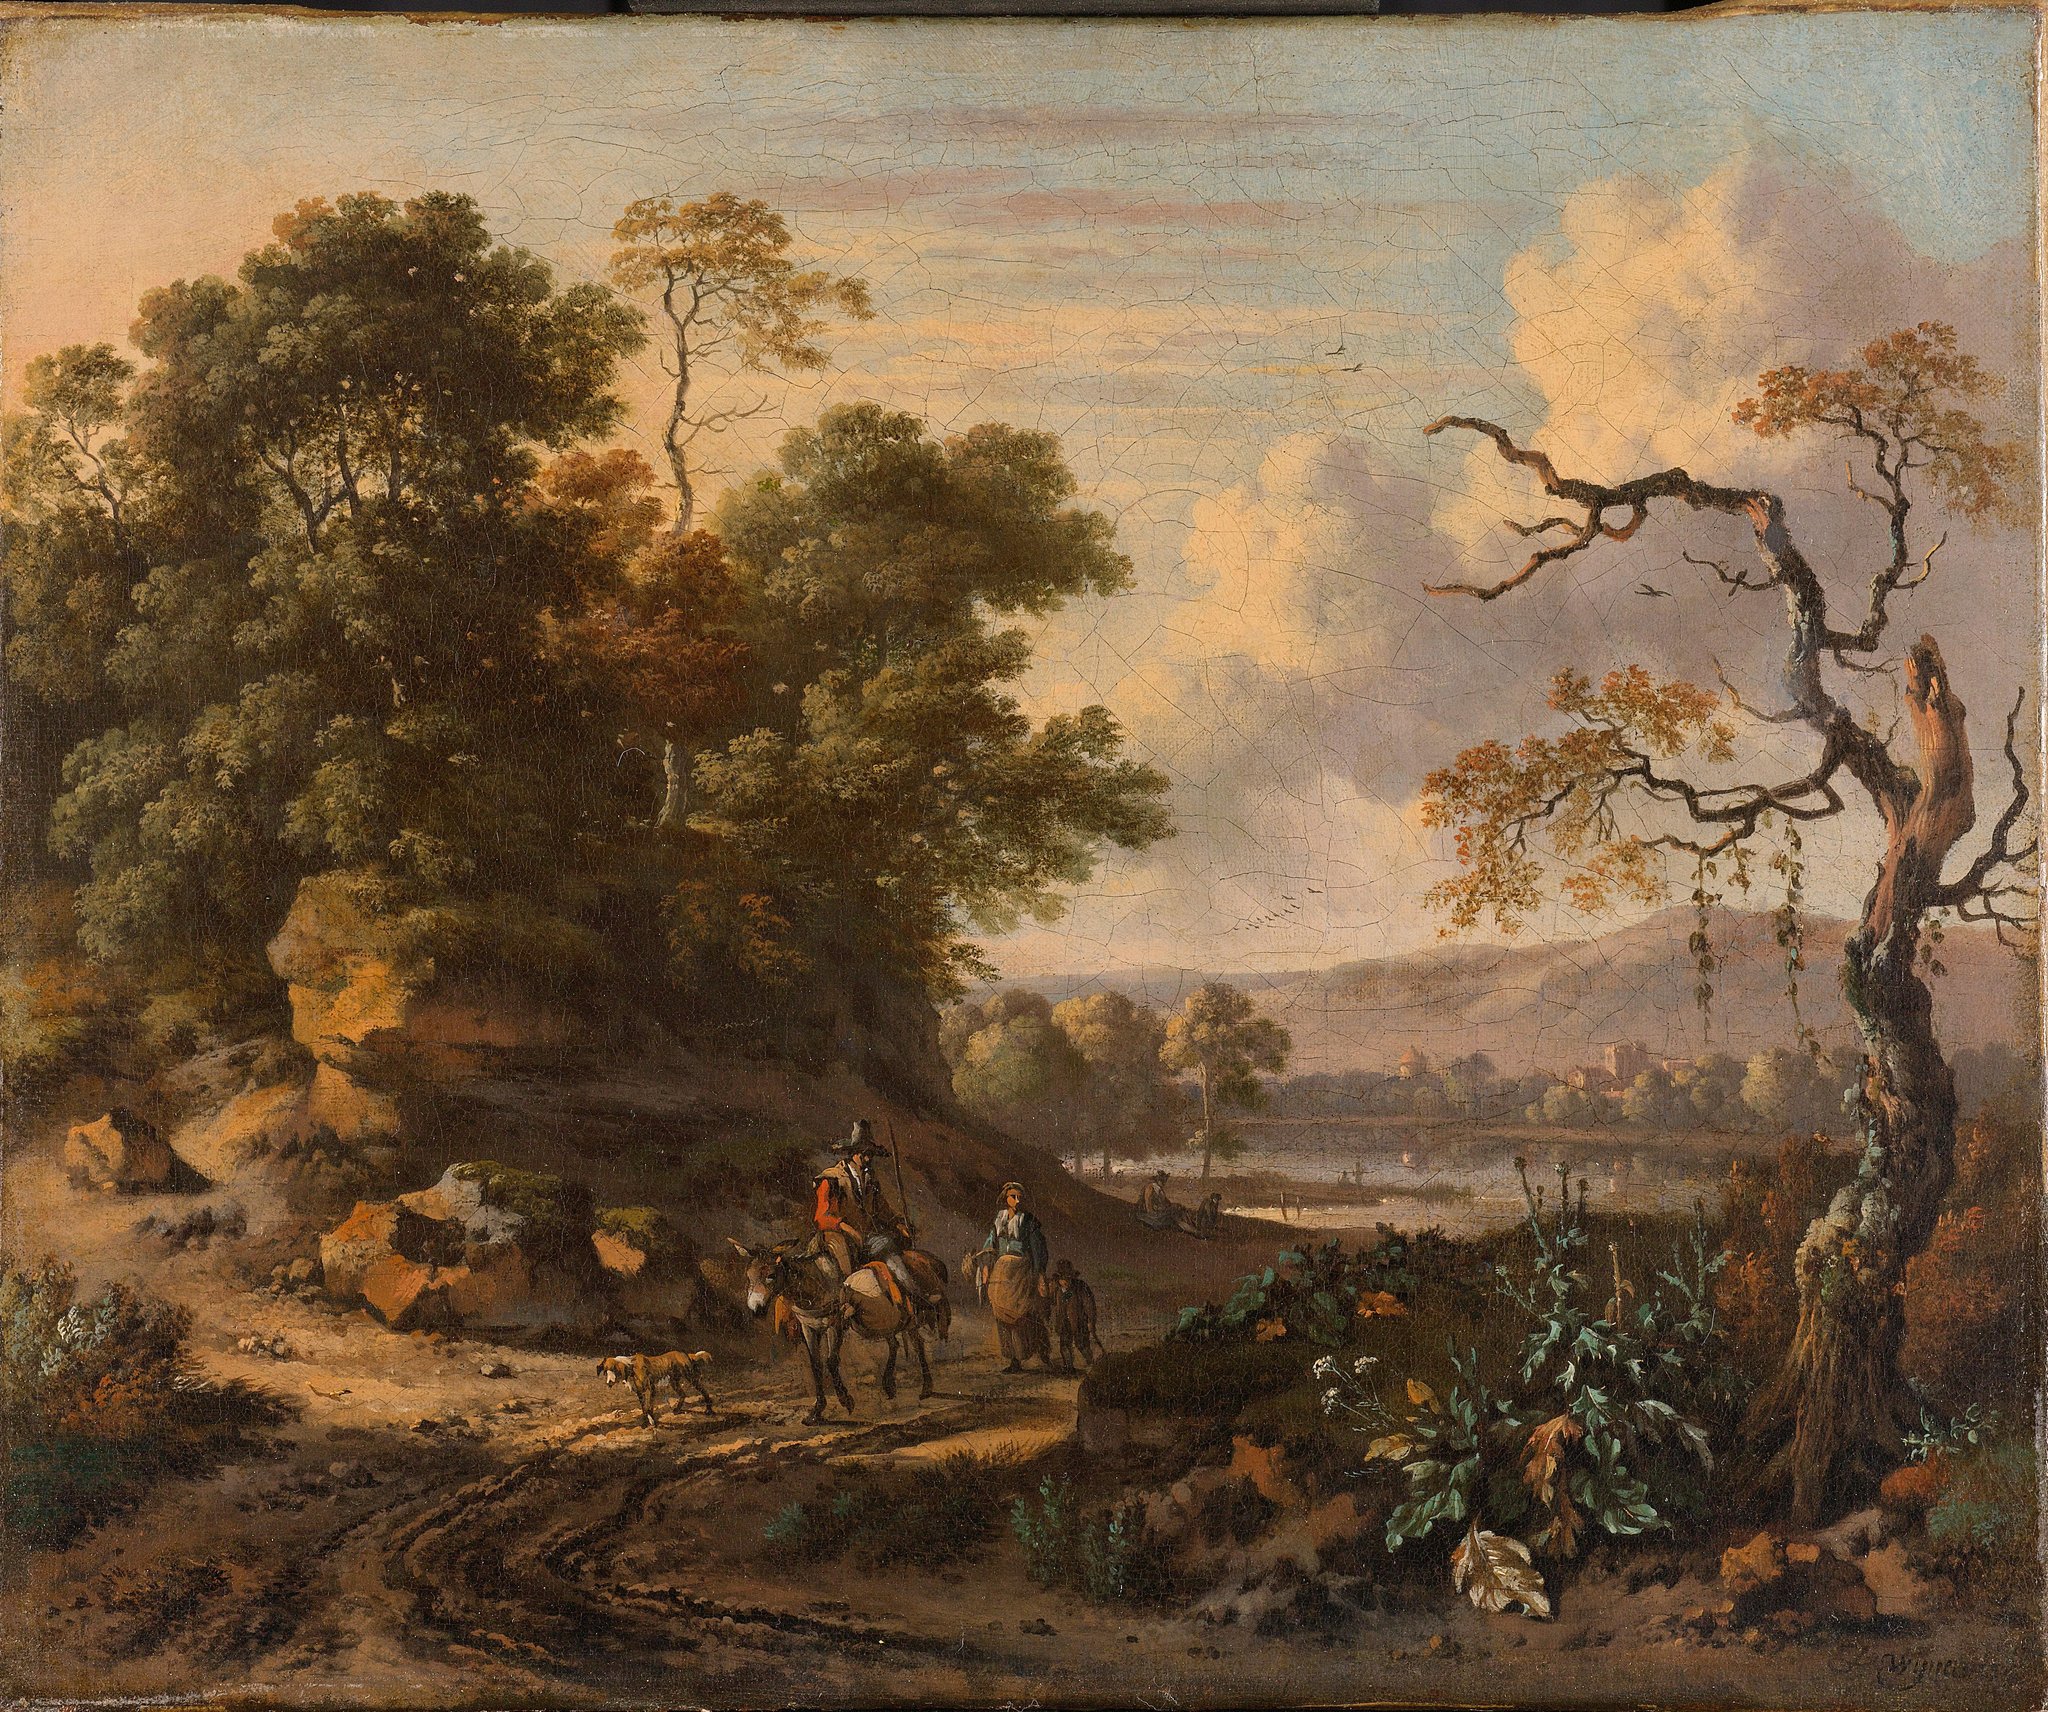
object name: painting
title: Landscape with a Man Riding a Donkey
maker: jan wijnants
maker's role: draughtsman, painter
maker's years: 1632-1684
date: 1655-1684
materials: canvas, oil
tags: riding a horse, ass, or mule; rider, horseman, low hill country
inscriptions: signature: ‘J. Wijnants’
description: Landschap waarin een man op een ezel over een landweg gaat, gevolgd door een vrouw met kind. Op de achtergrond een kasteel aan een meer voor een heuvelrug.